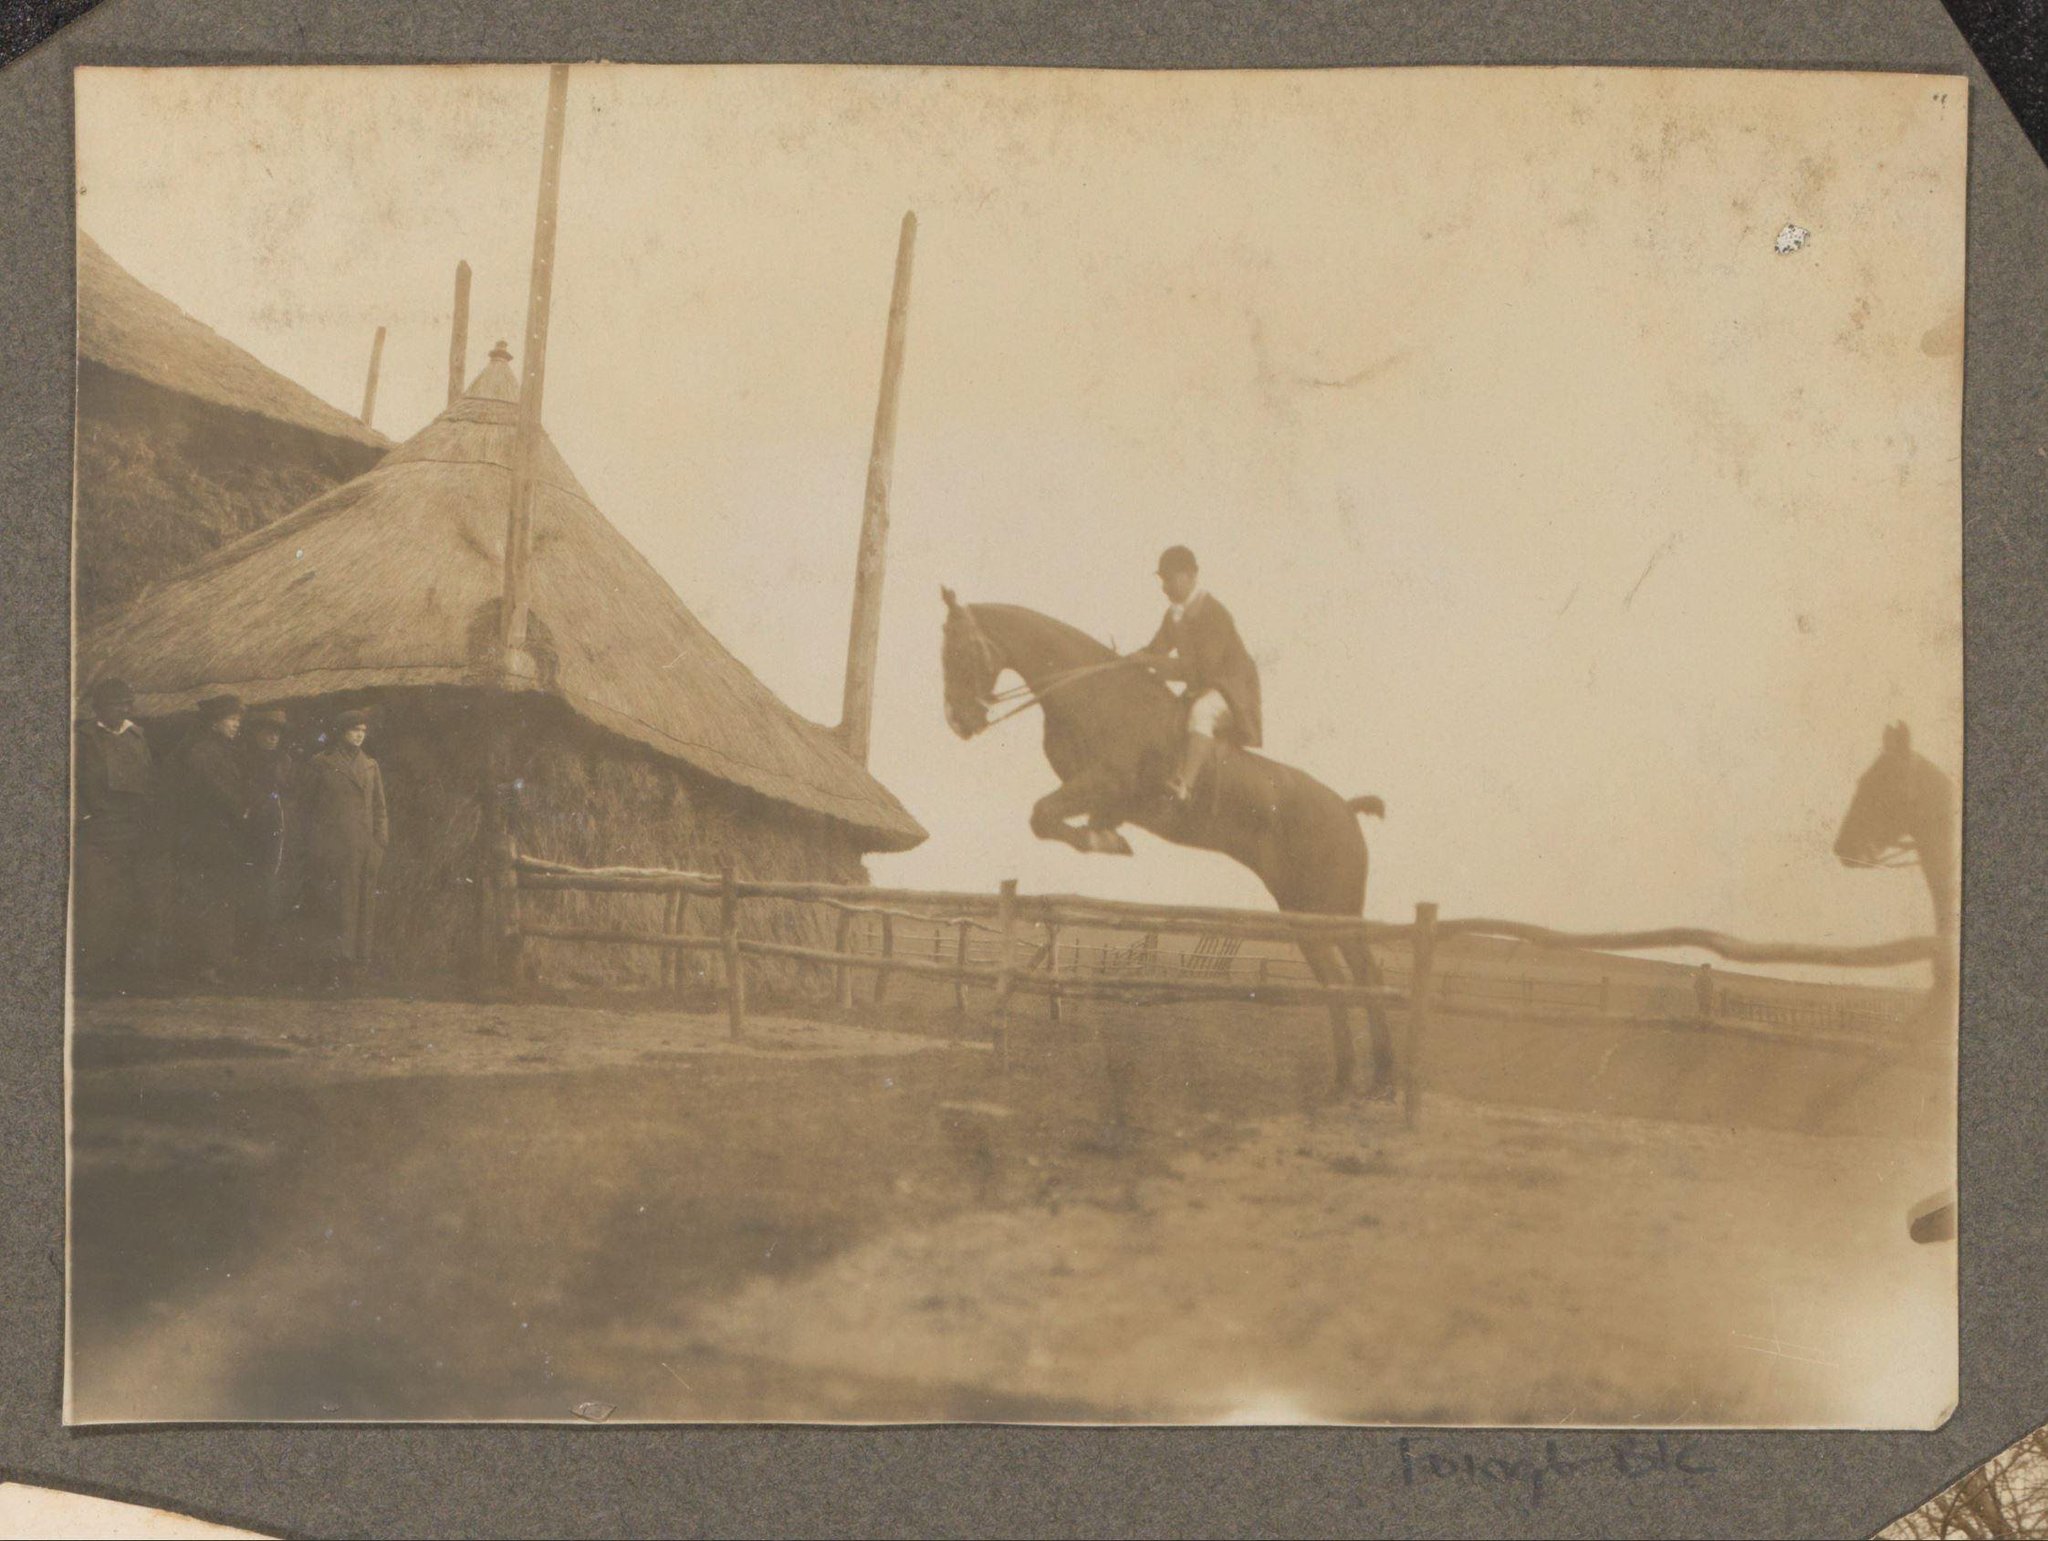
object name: album leaf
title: Ruitertafereel op Koninklijke Houtvesterij Het Loo: ruiter neemt hindernis bij een hooiberg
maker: Anonymous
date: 1900-1925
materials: photographic support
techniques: gelatin silver print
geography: het loo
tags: riding a horse, ass, or mule; rider, horseman, hunting-ground, jumping (horse in motion), hay-stack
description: Onderdeel van Fotoalbum van de heer Brams, opperhoutvester van koningin Wilhelmina op Koninklijke Houtvesterij Het Loo.